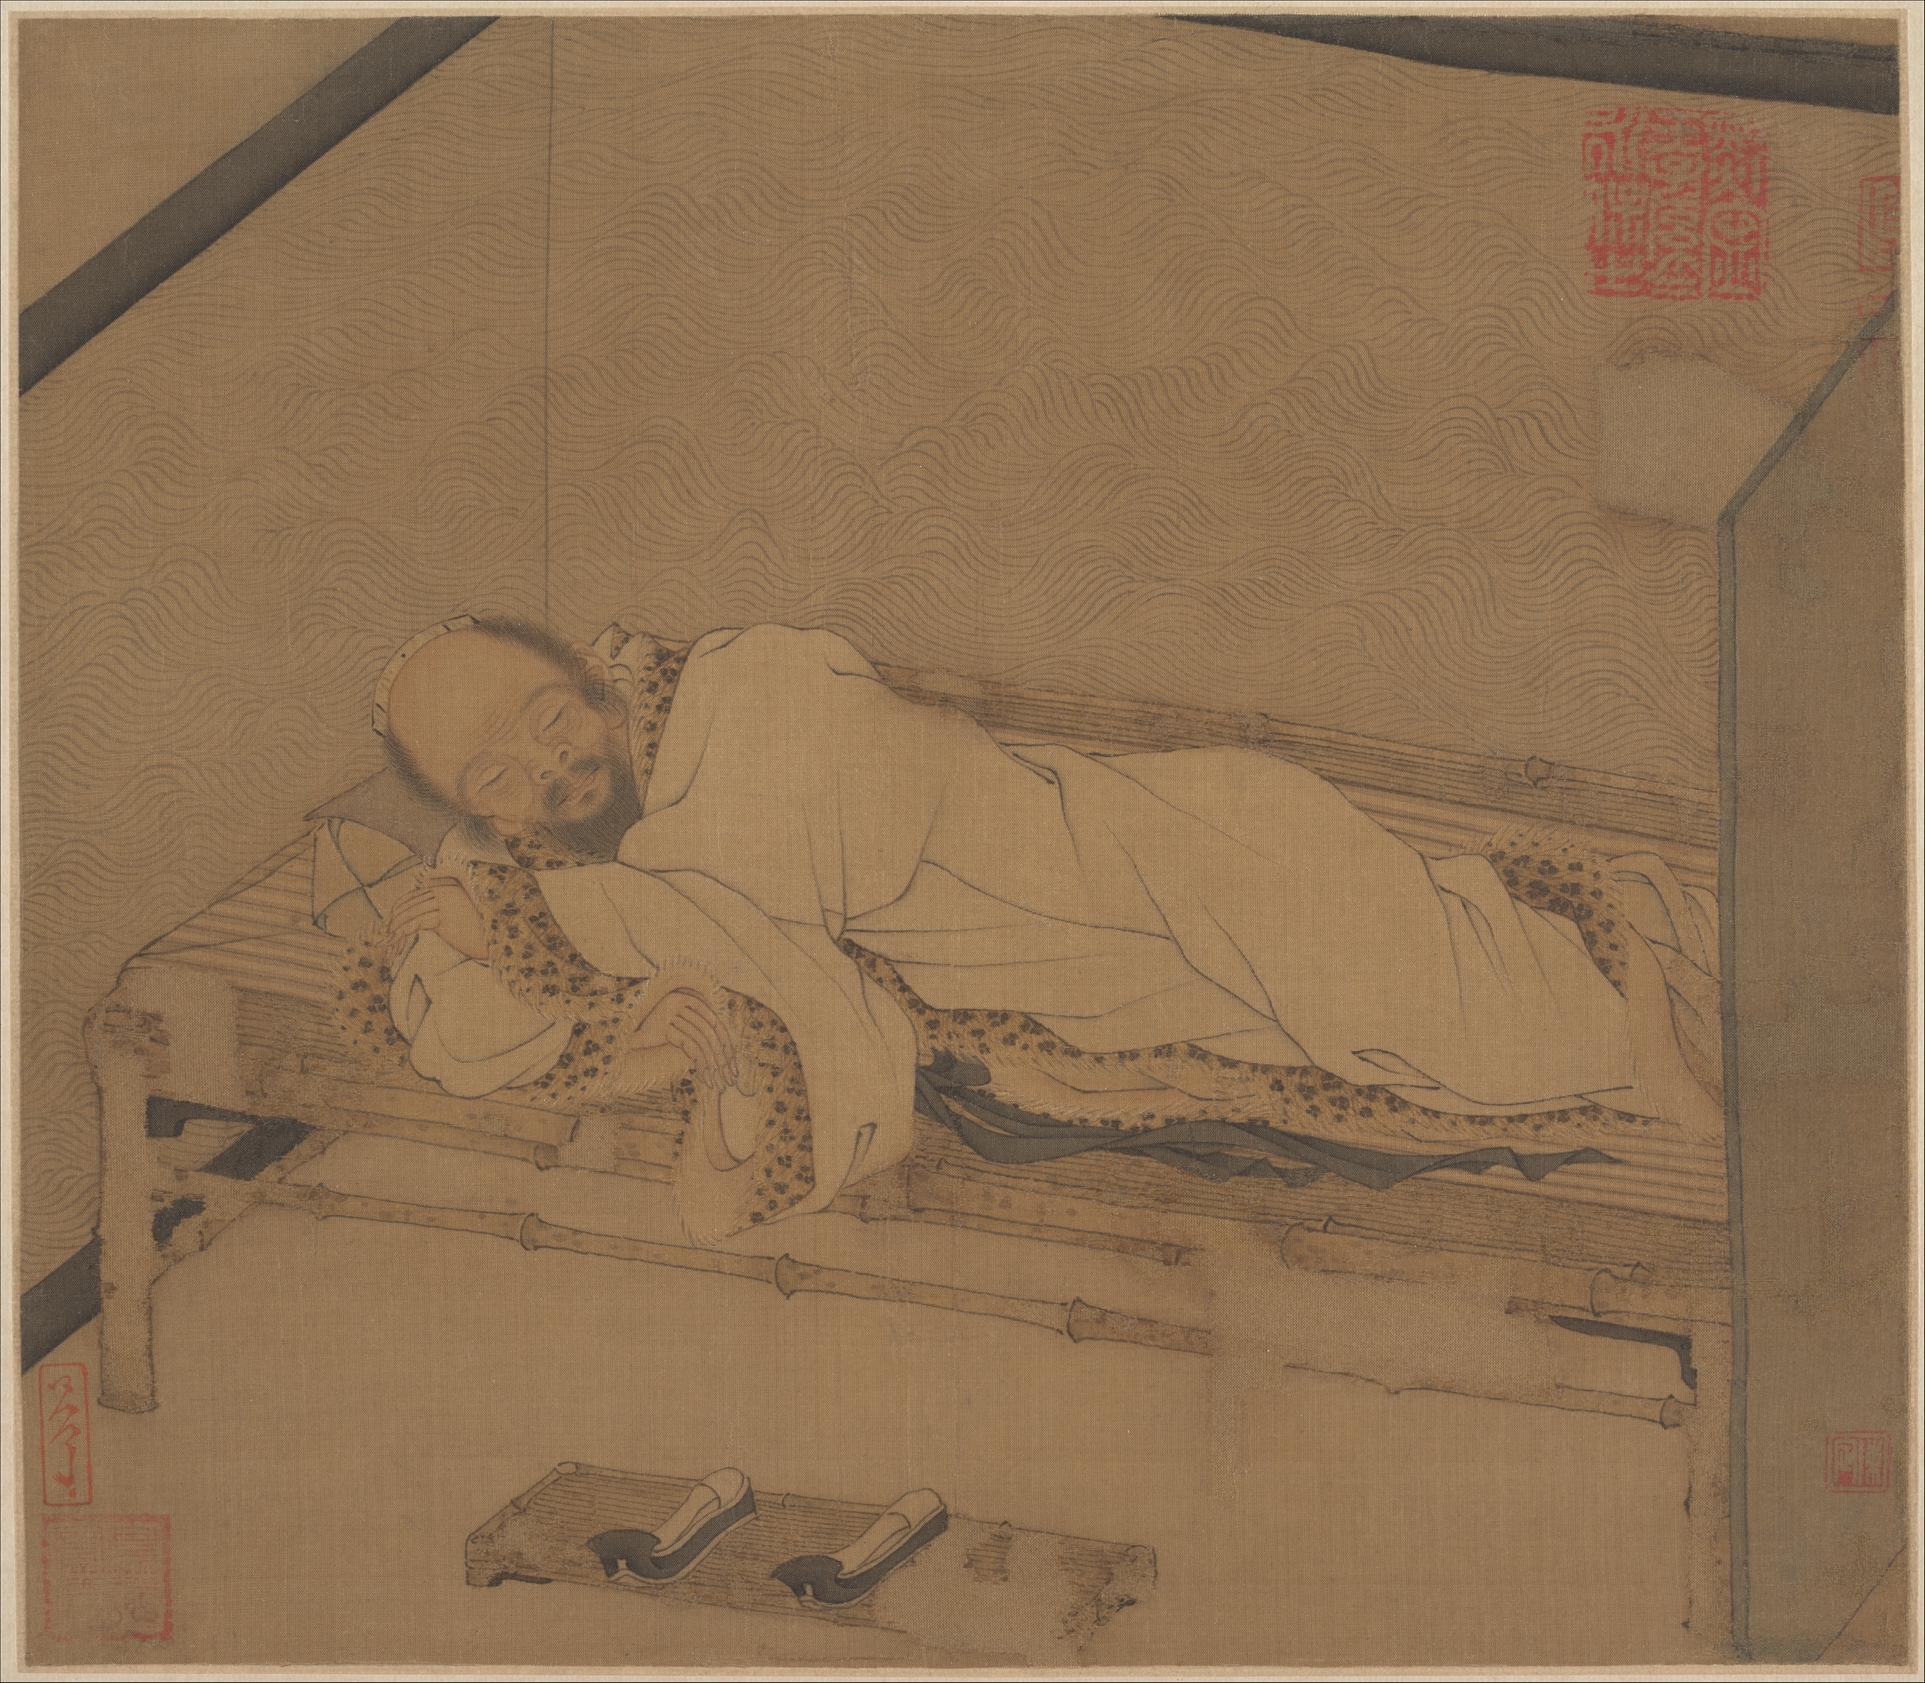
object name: album leaf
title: Man Sleeping on a Bamboo Couch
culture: chinese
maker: unidentified artist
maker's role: artist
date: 1300-1435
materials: ink, silk